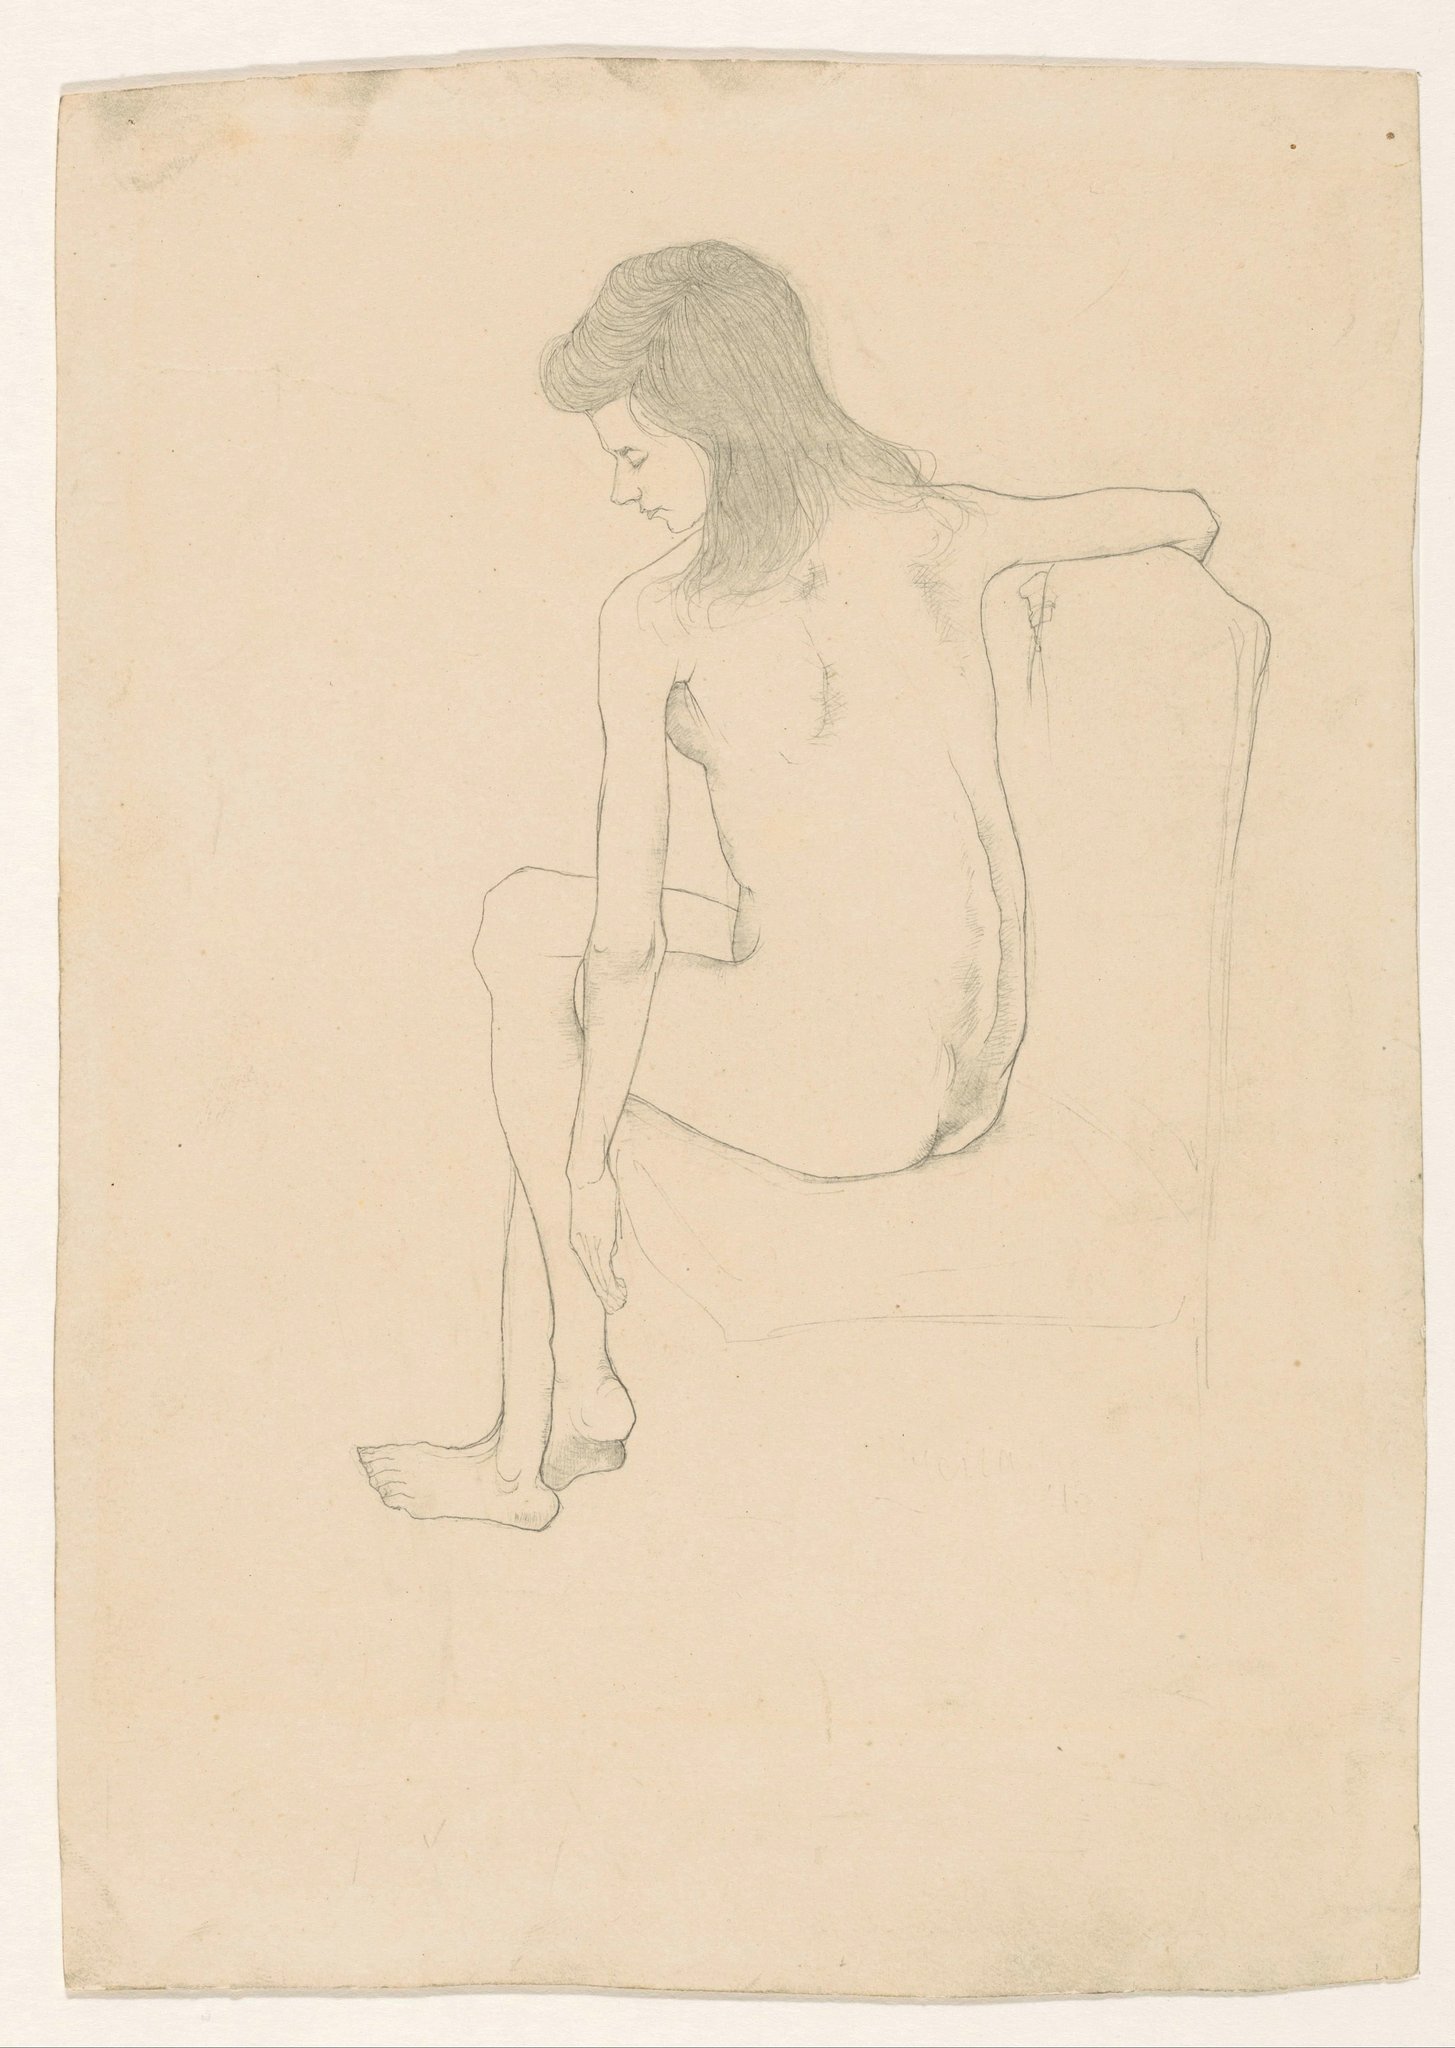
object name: drawing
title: Vrouwelijk naakt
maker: jan mankes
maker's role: draughtsman, painter, print maker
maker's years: 1889-1920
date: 1906-1913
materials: paper, pencil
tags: sitting figure - aa - female human figure, the (nude) human figure; 'corpo humano' (ripa) - aa - female human figure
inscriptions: collector's mark: Lugt 2228